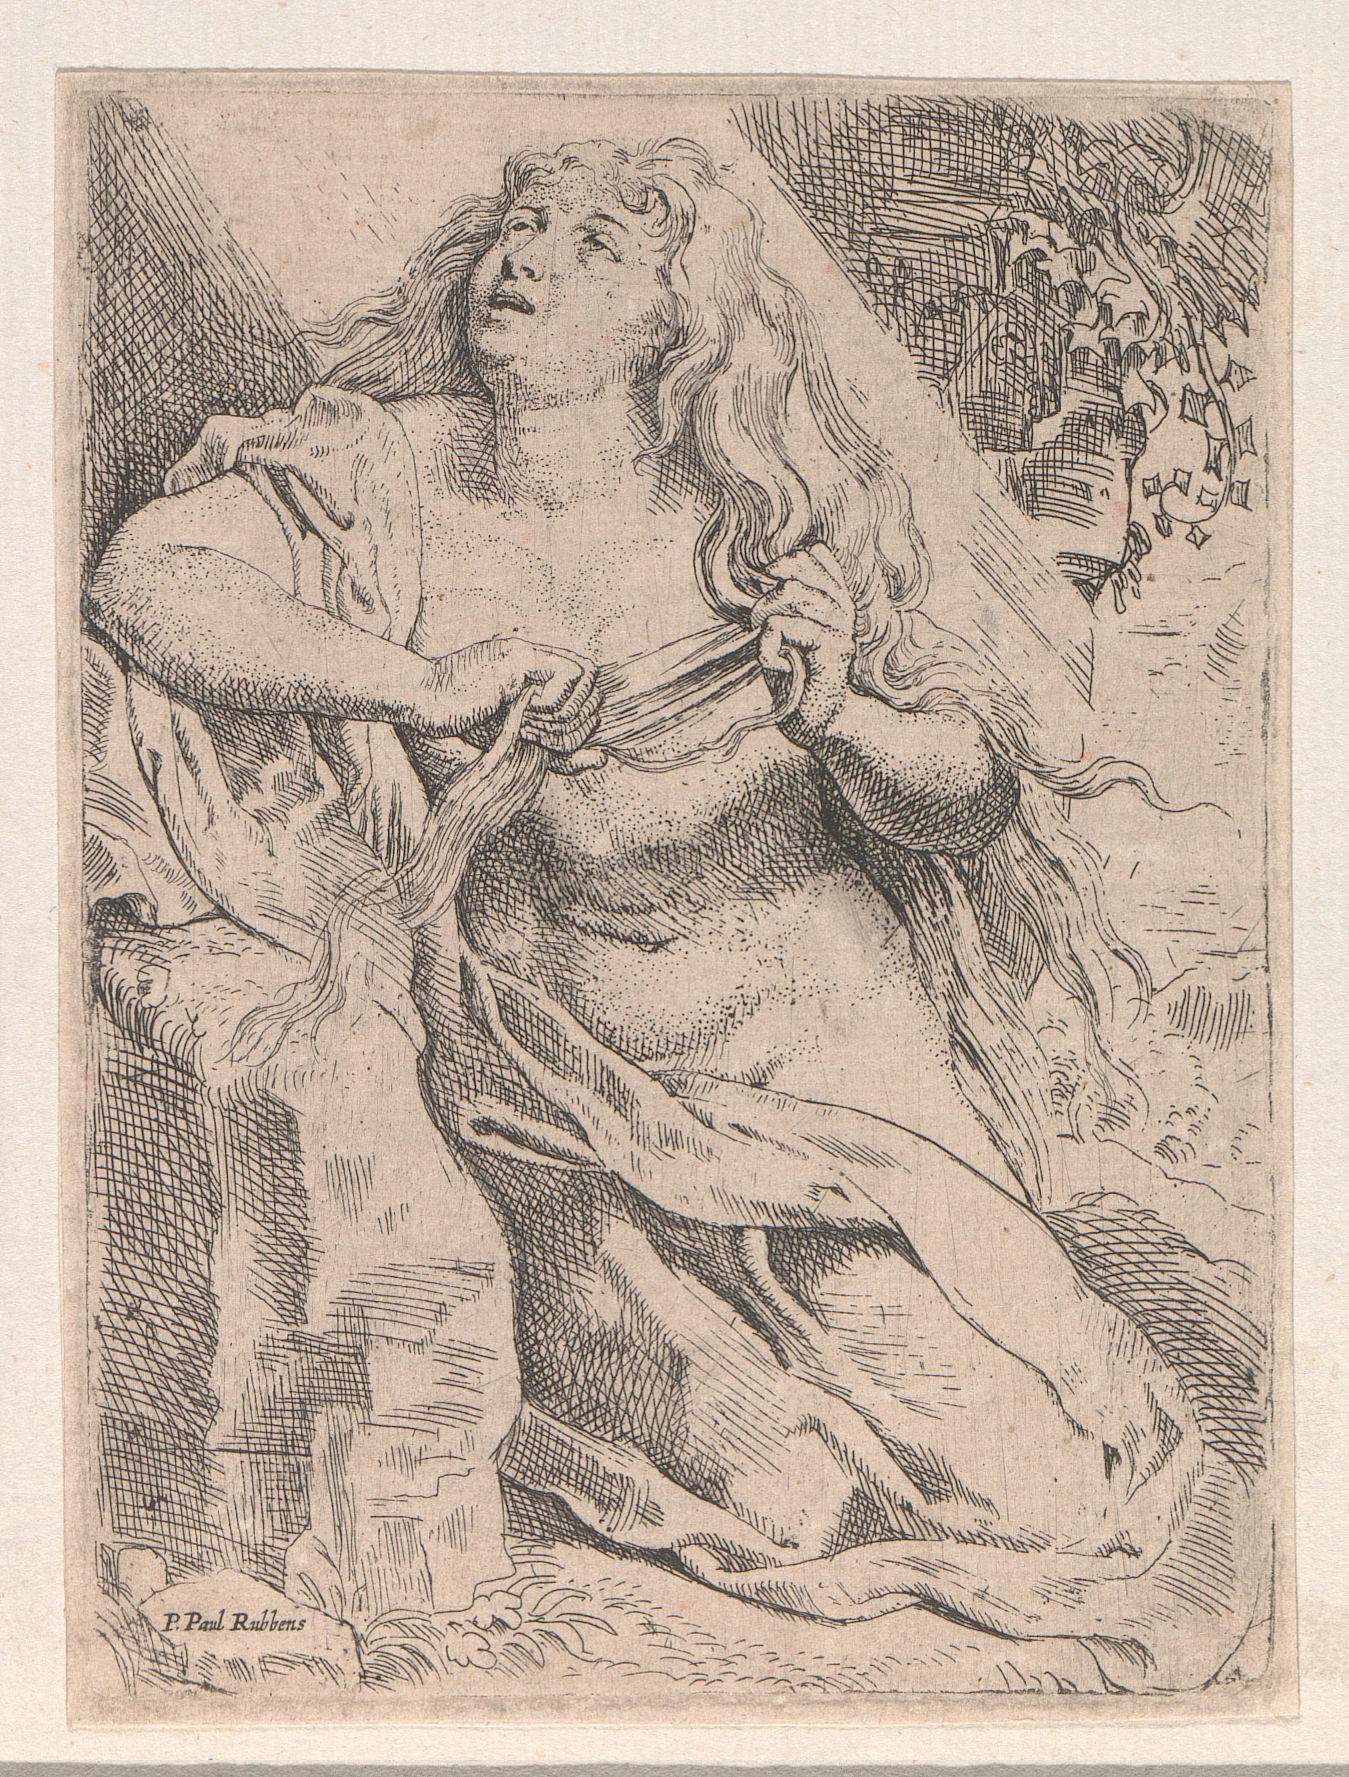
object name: album leaf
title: Maria Magdalena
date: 1613-1614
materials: paper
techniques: engraving, etching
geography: northern netherlands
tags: the penitent harlot mary magdalene; possible attributes: book (or scroll), crown, crown of thorns, crucifix, jar of ointment, mirror, musical instrument, palm-branch, rosary, scourge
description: Boetvaardige Maria Magdalena in de wildernis. Mogelijk een paar samen met de prent van H. Franciscus die de stigmata ontvangt. Deze prent maakt deel uit van een album.